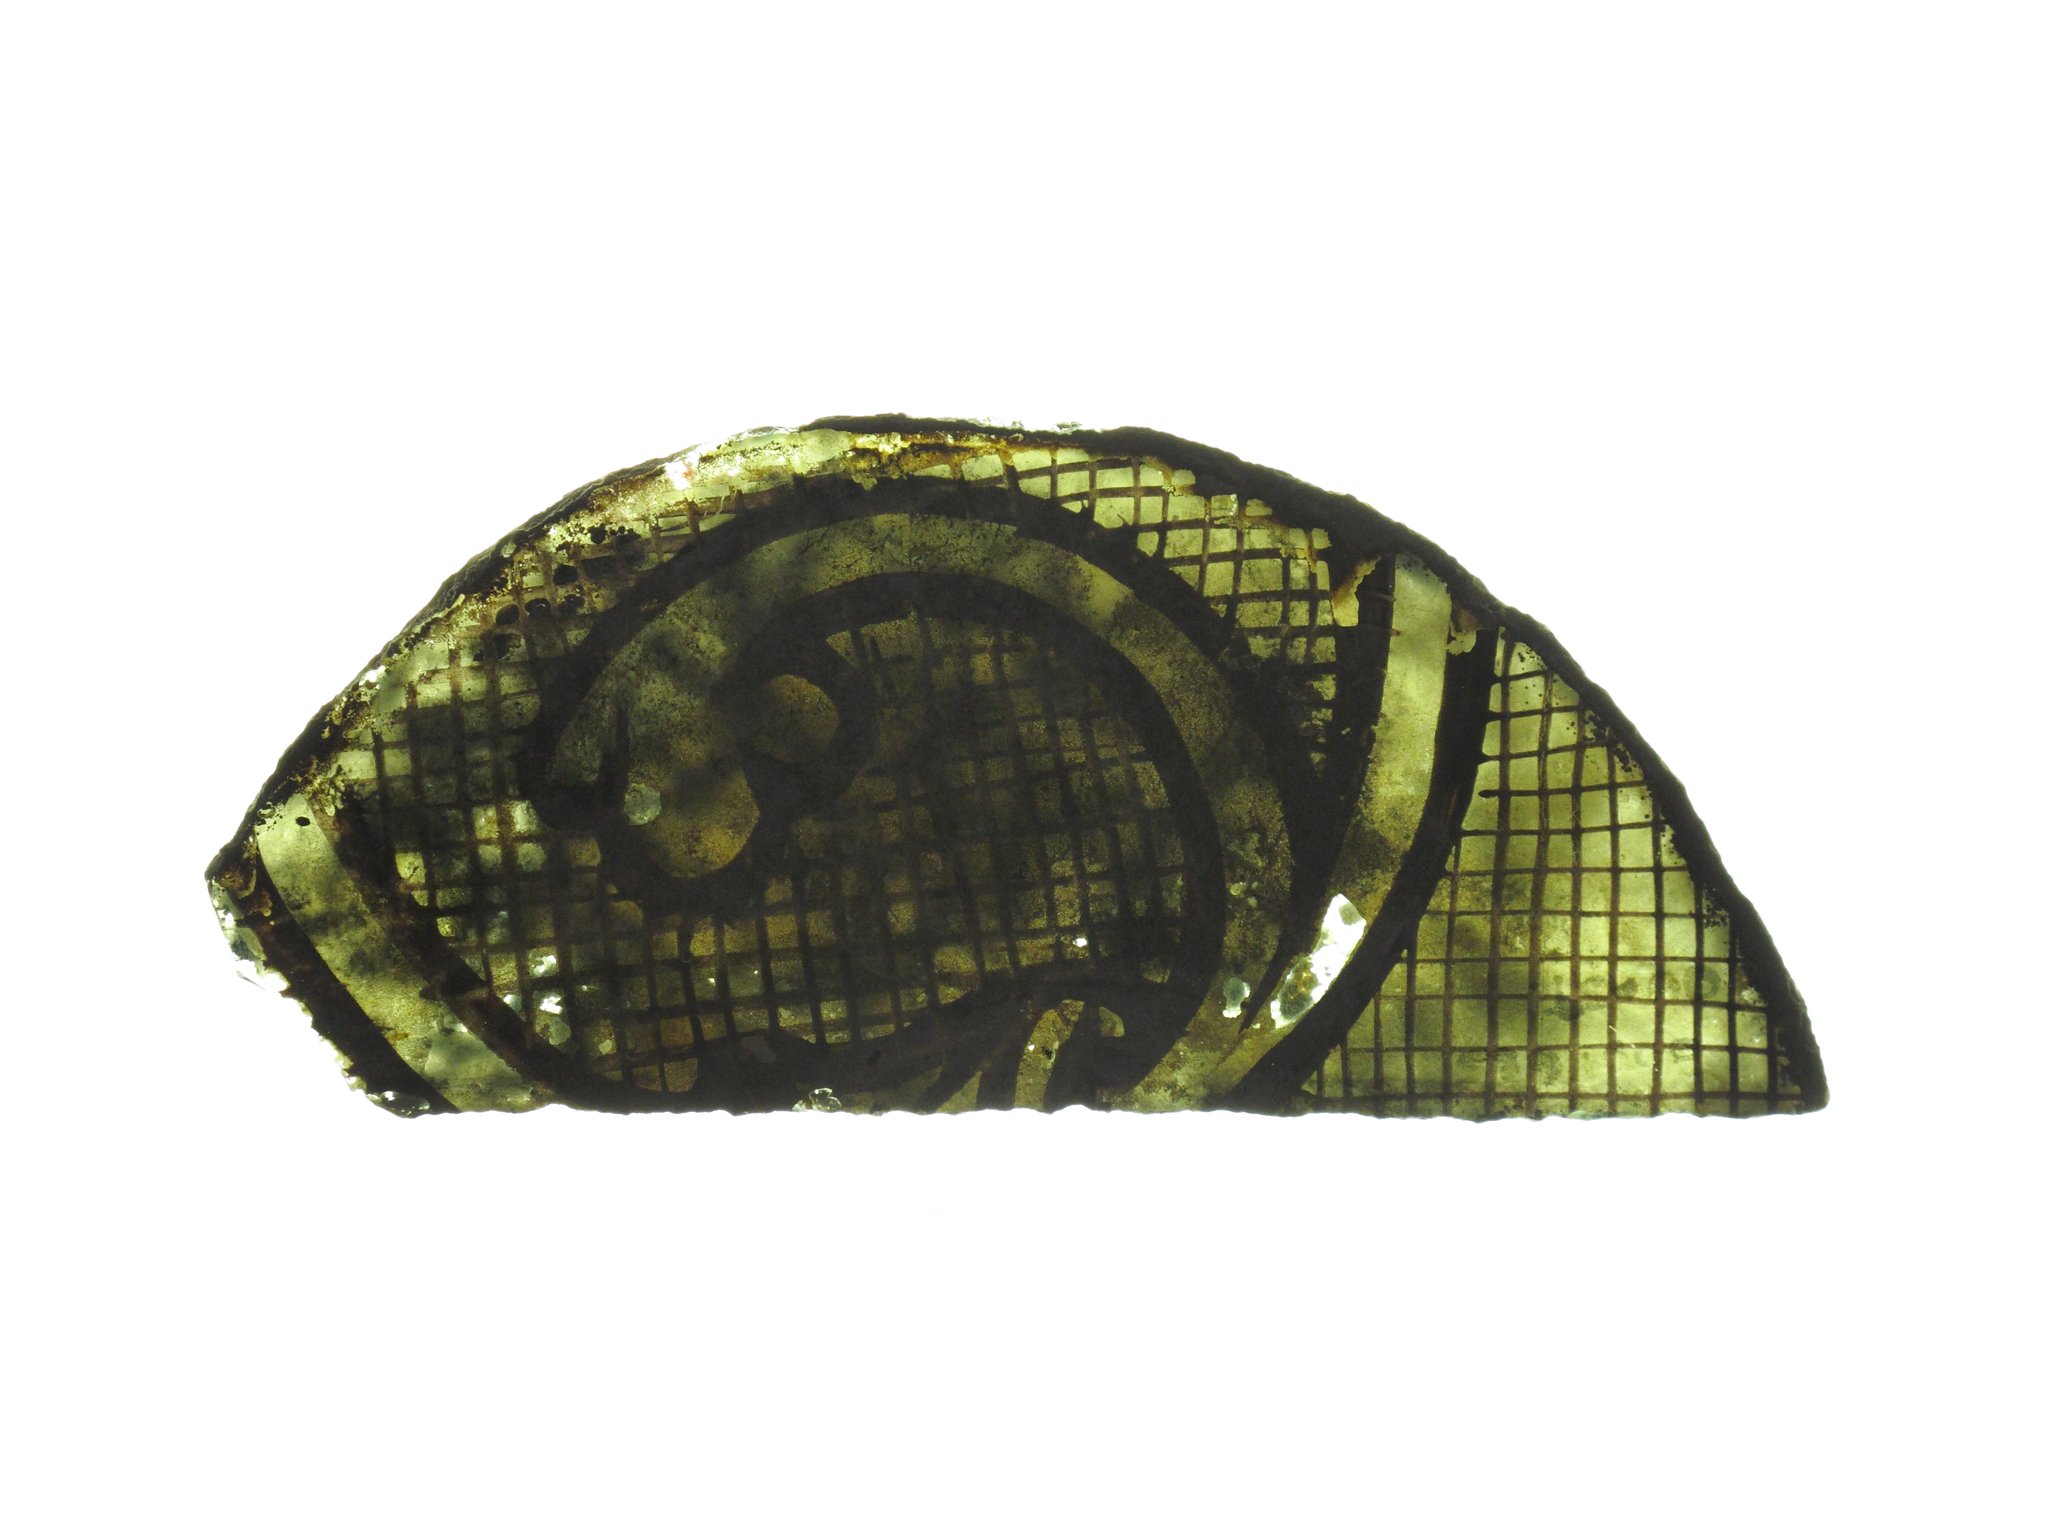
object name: fragment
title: Glass Fragment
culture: french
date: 1201-1300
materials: glass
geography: france